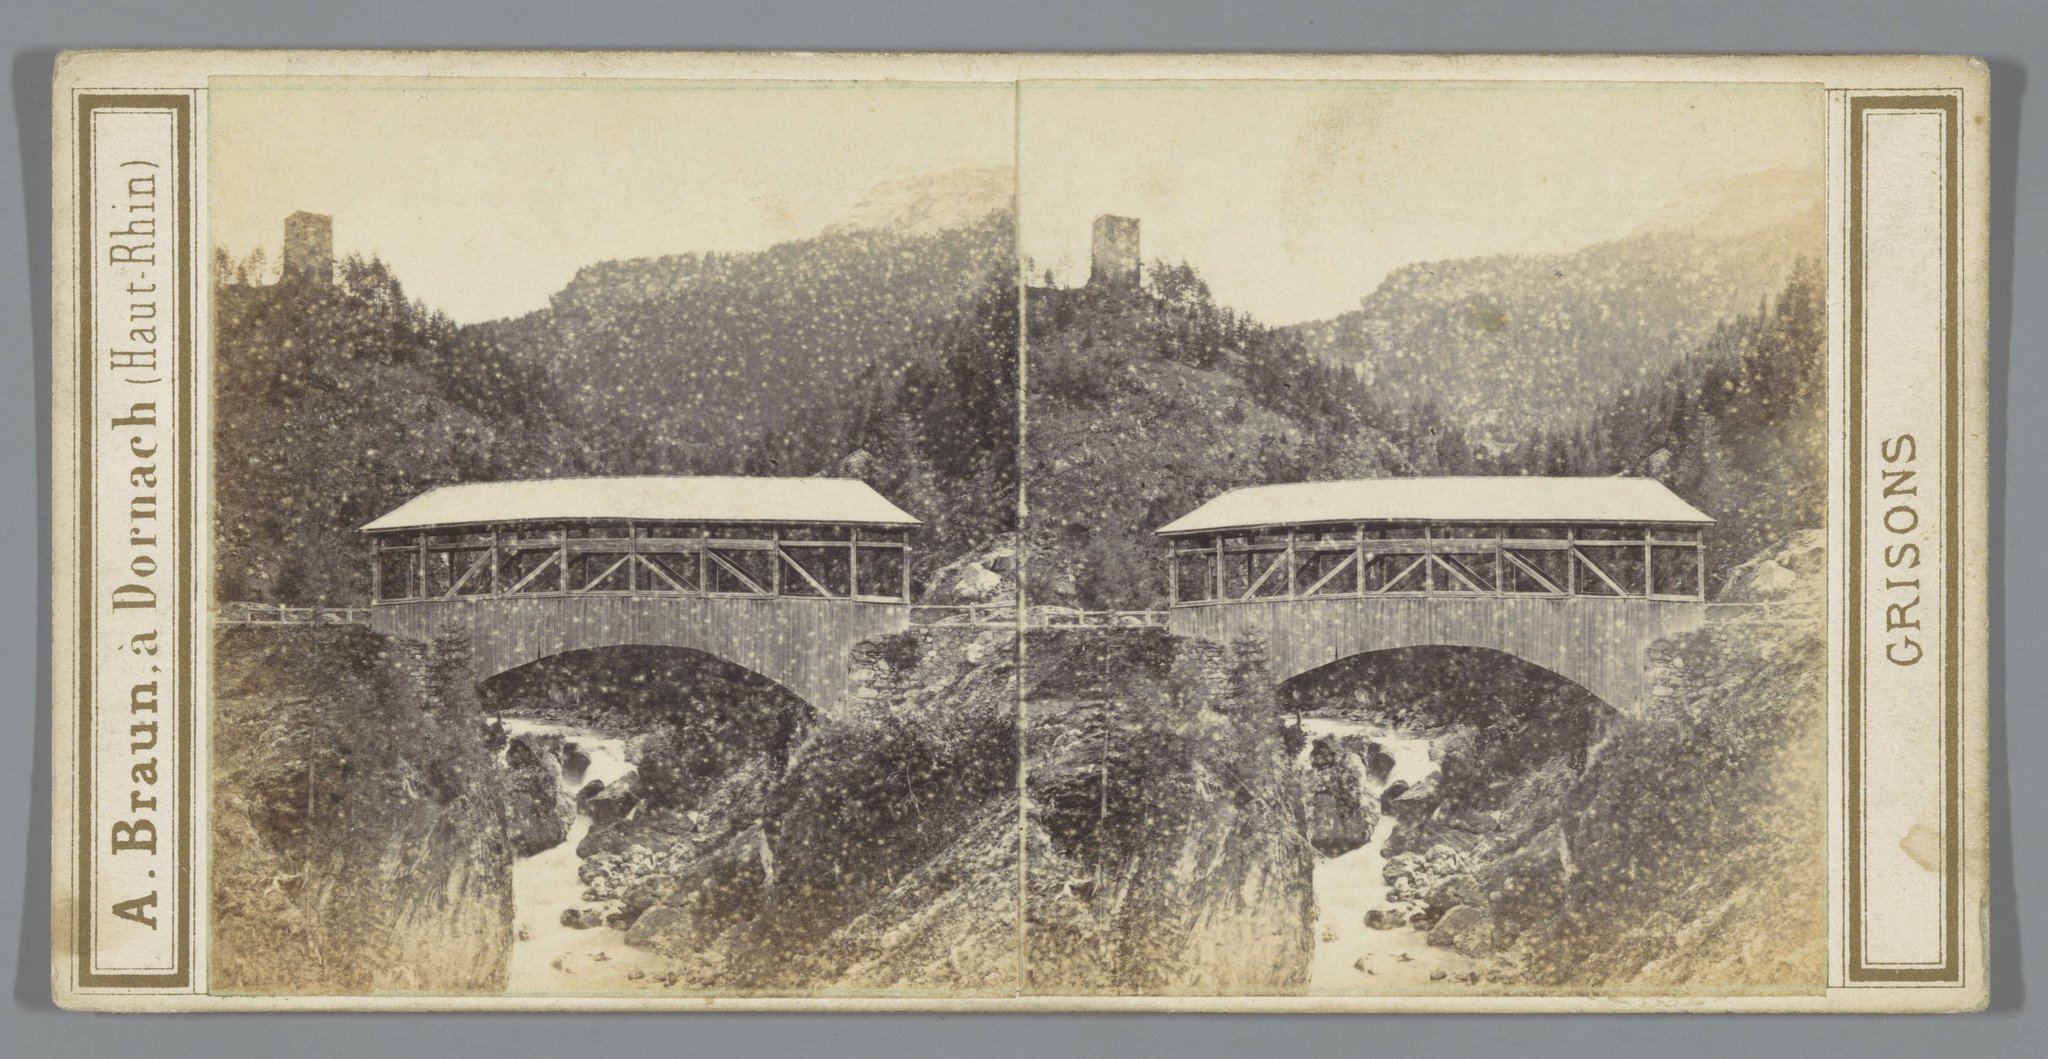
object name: stereograph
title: Canton des Grisons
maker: Anonymous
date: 1860-1866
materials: cardboard, paper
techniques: albumen print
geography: dornach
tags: river, landscape with bridge, viaduct or aqueduct, julia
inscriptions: number: ‘No 3352’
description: Titel op object is incorrect. De afgebeelde rivier is de Gelgia, niet de Rijn.